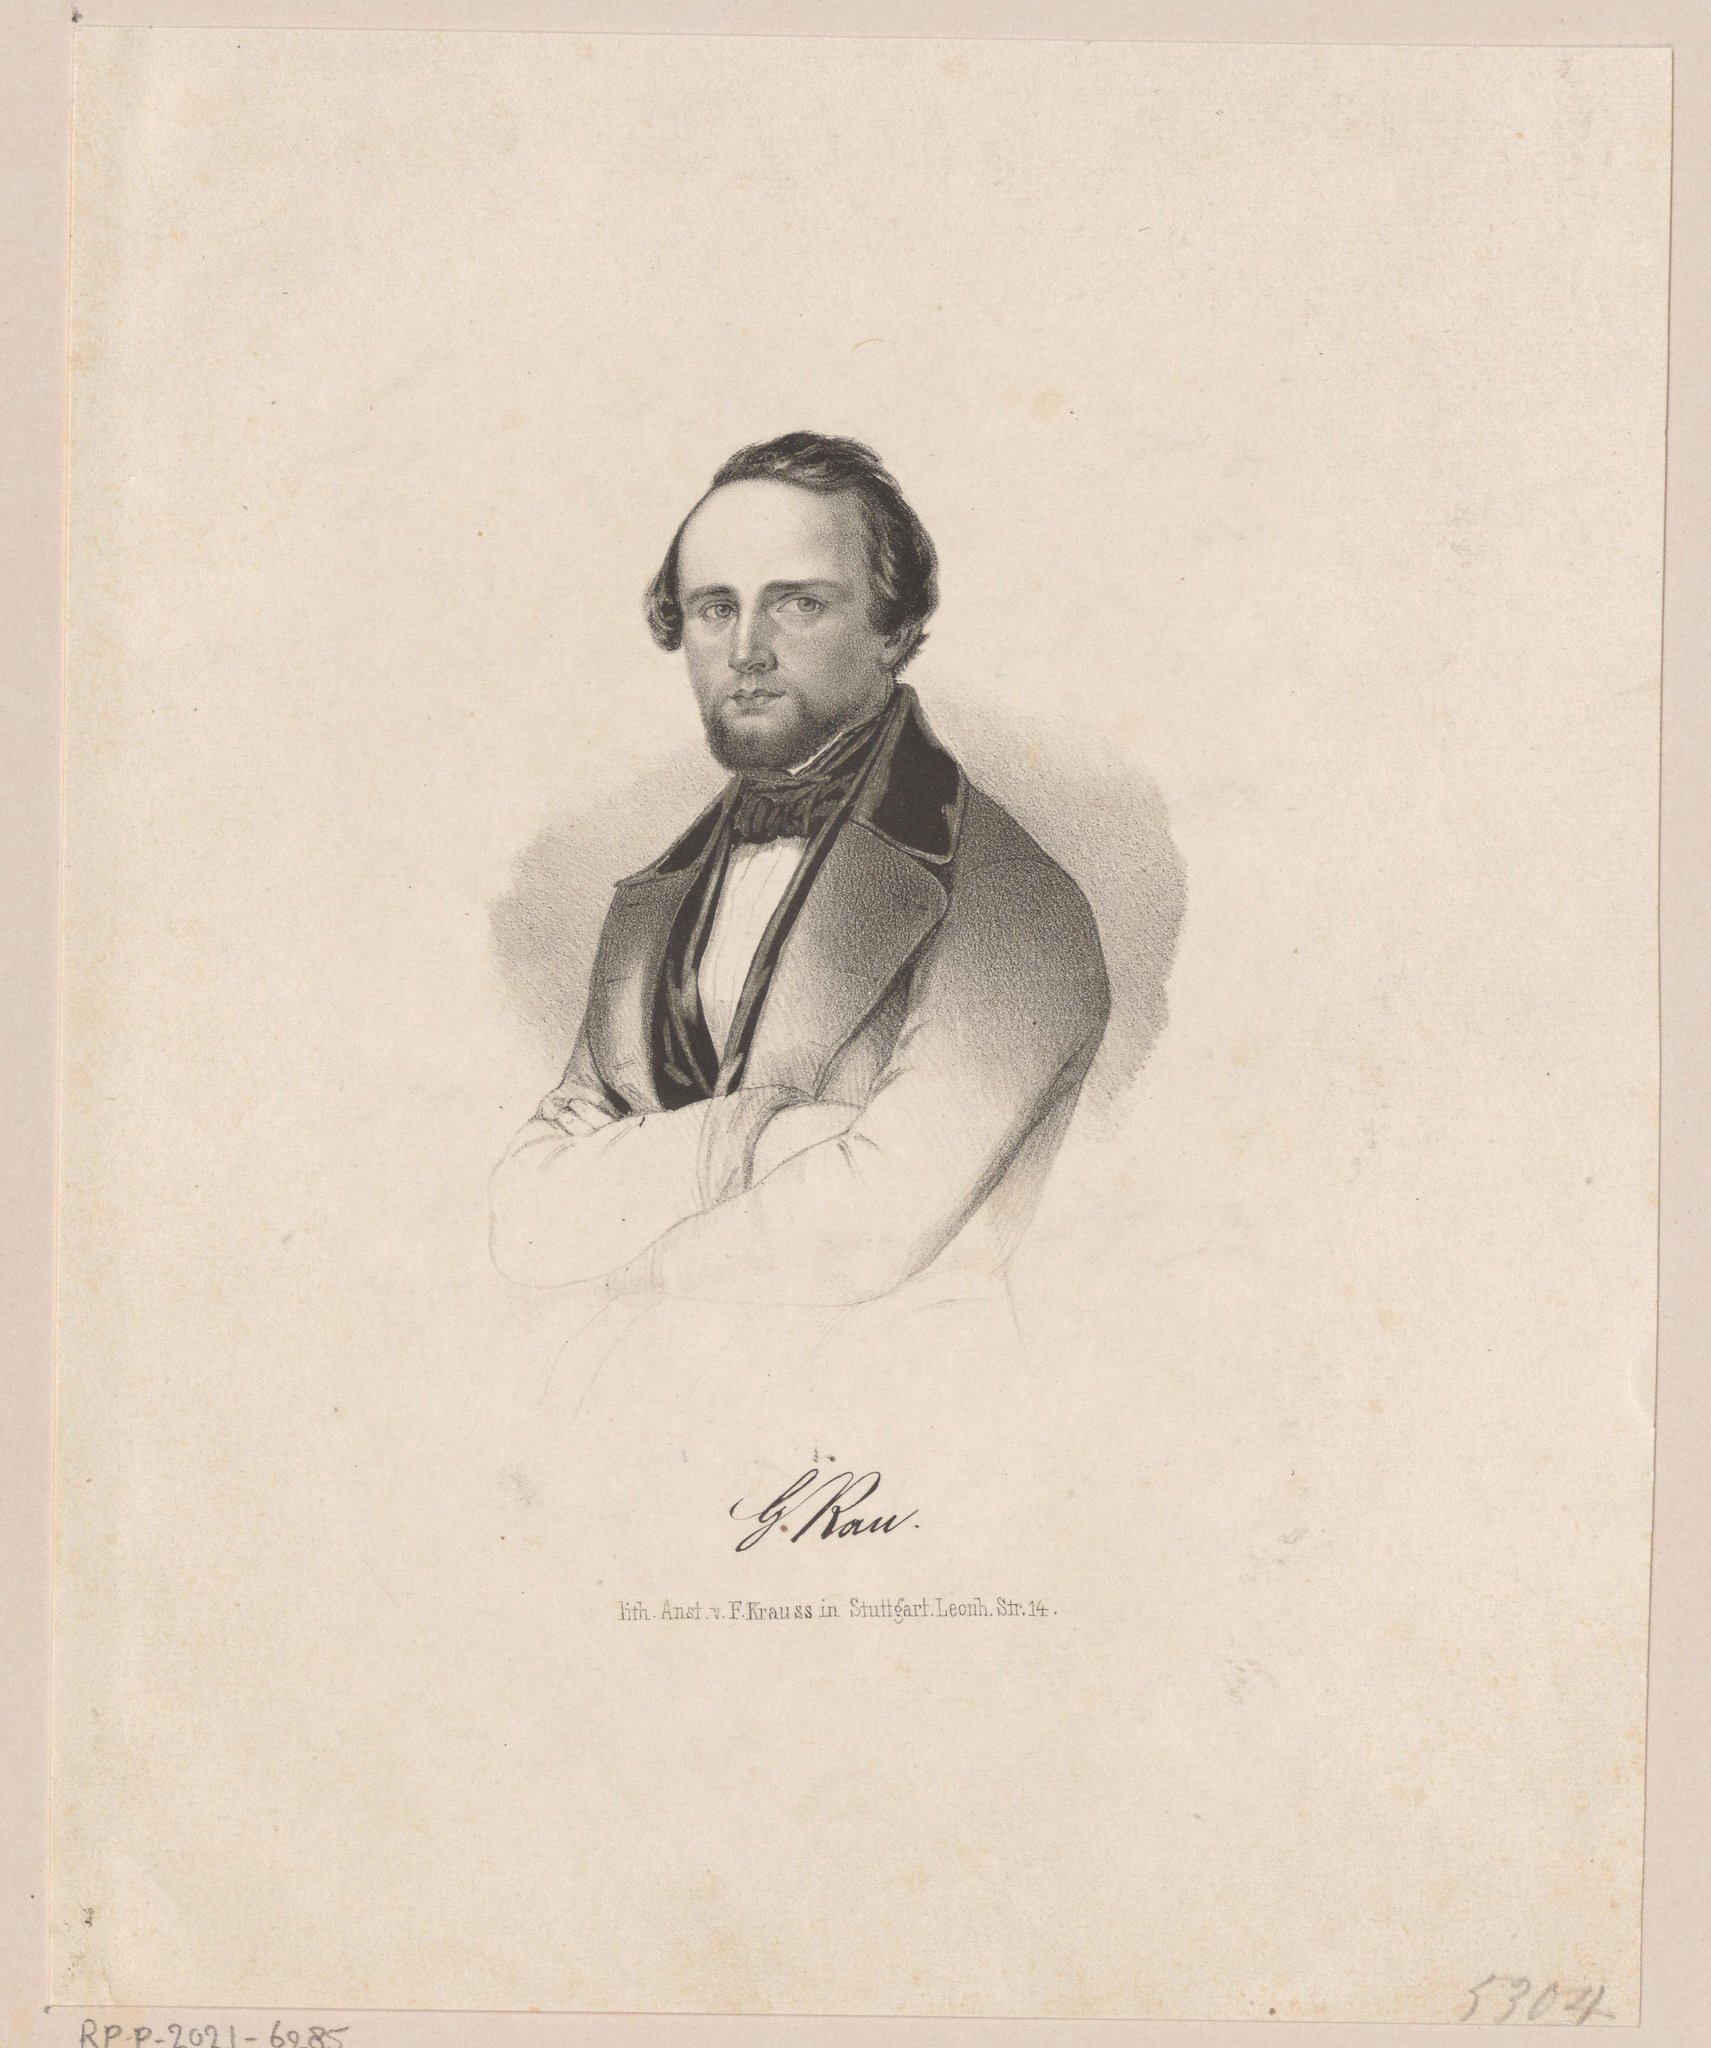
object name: print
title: Portret van Gottlieb Rau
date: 1826-1899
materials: paper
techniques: lithograph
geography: stuttgart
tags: historical persons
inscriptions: collector's mark: Lugt 2228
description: Onder het portret een facsimile van de handtekening van de geportretteerde.